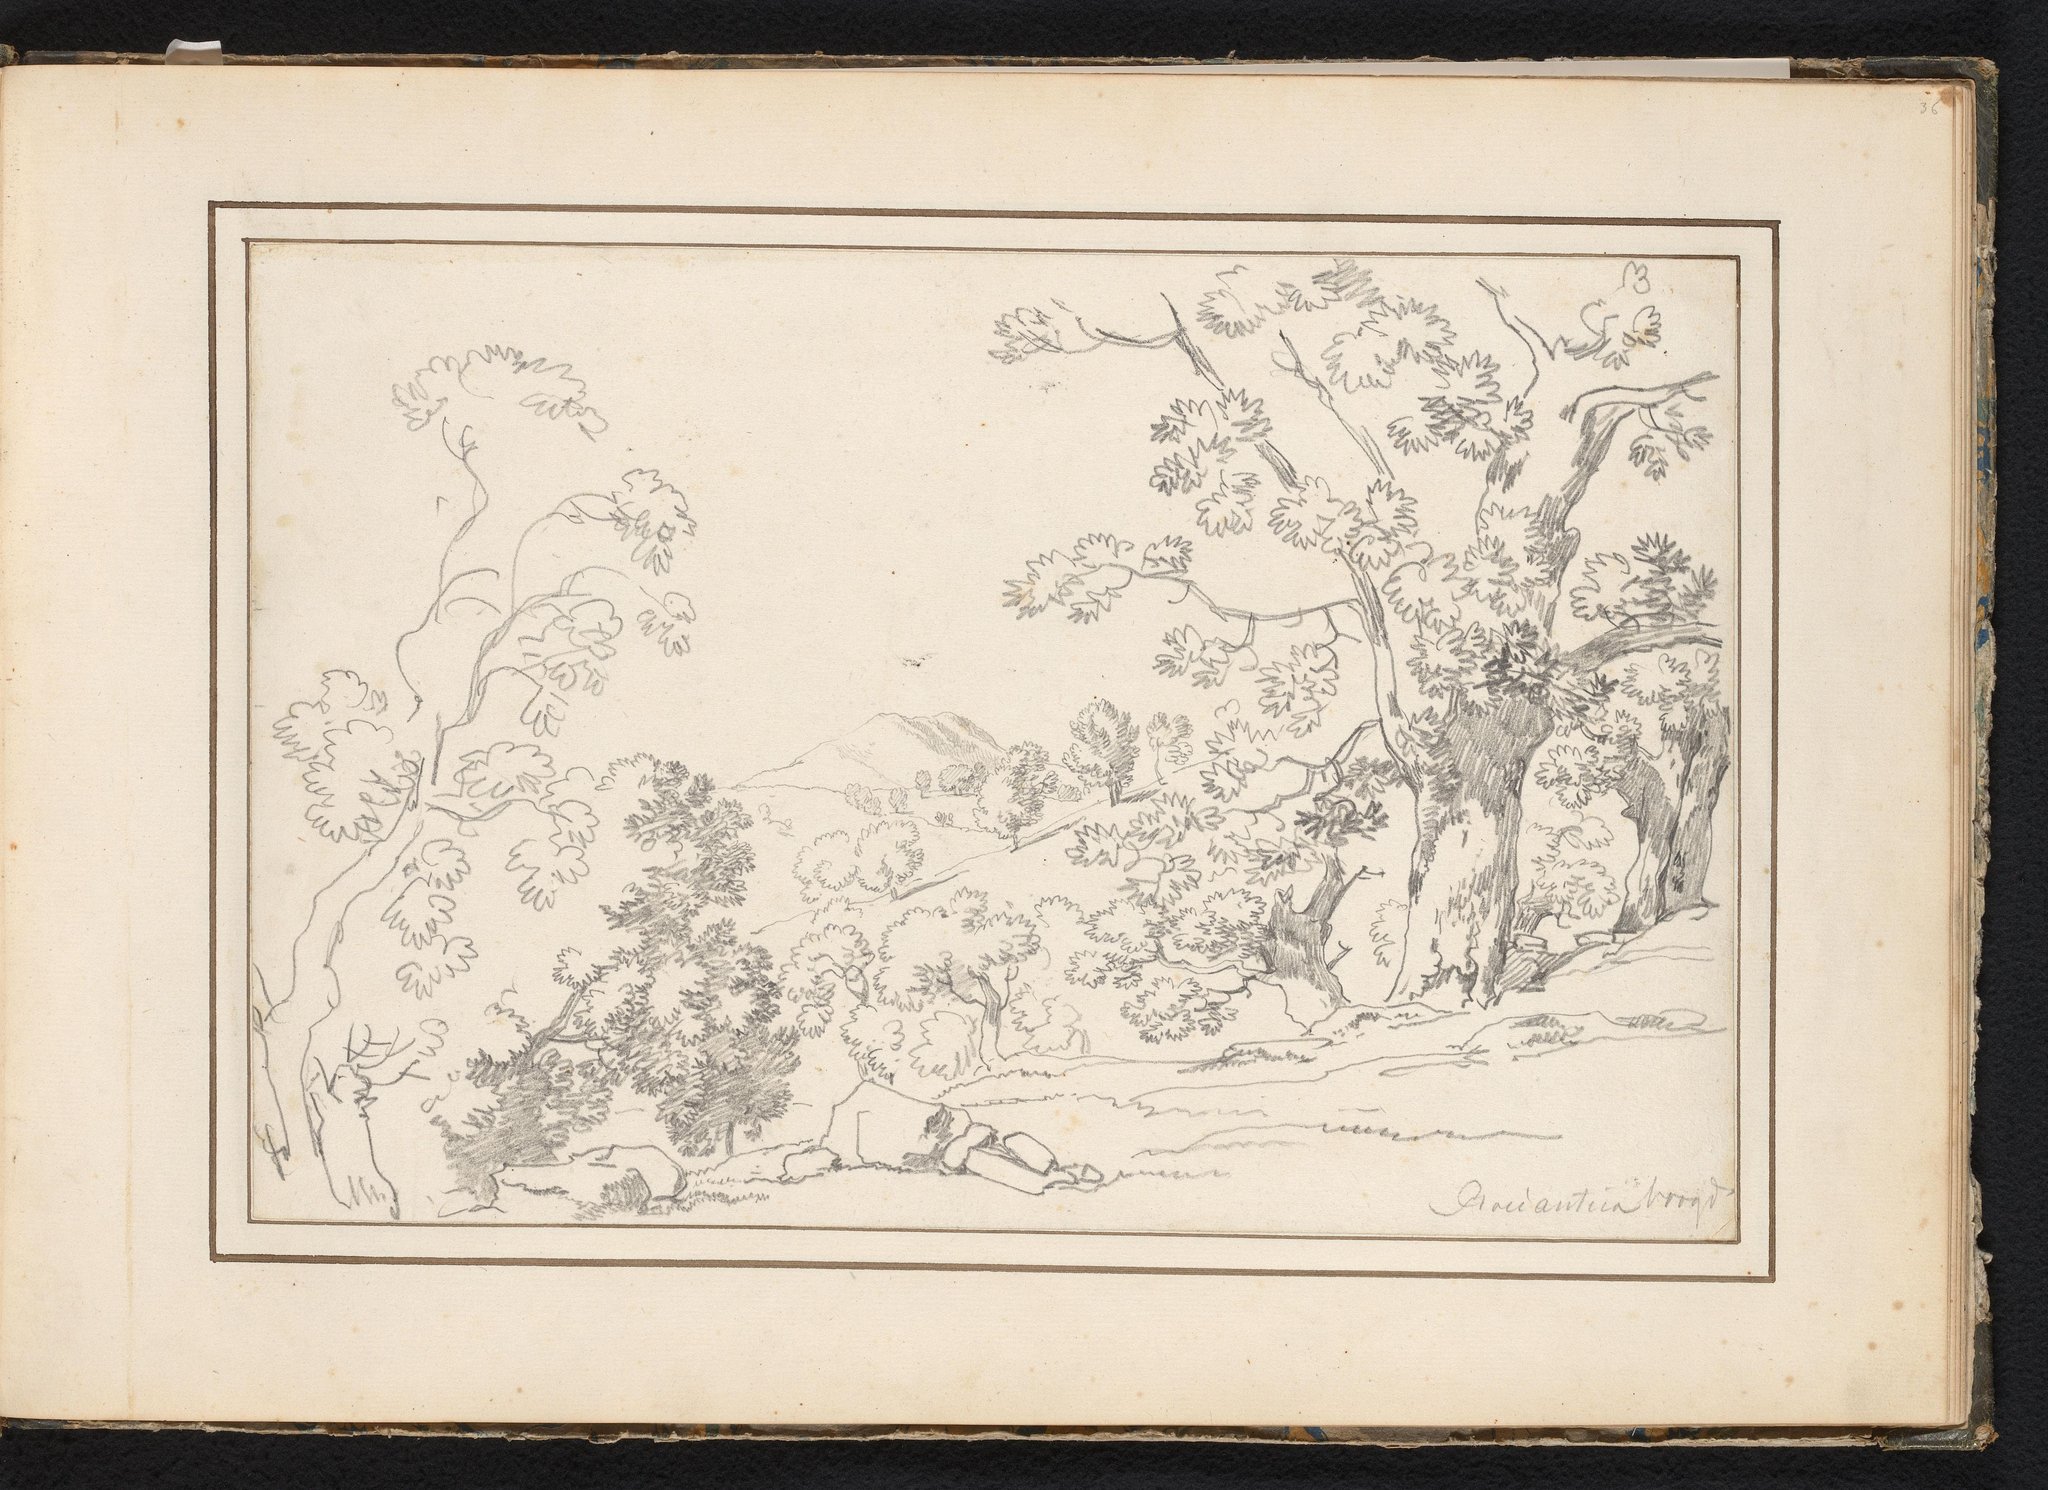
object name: album leaf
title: Vergezicht met bomen en een bergtop te Roccantica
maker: hendrik voogd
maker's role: draughtsman, painter, print maker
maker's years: 1768-1839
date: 1788-1839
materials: paper, pencil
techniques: pasting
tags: landscapes, mountain-top, peak, groups of trees, roccantica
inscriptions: inscription: ‘Rocc'antica’